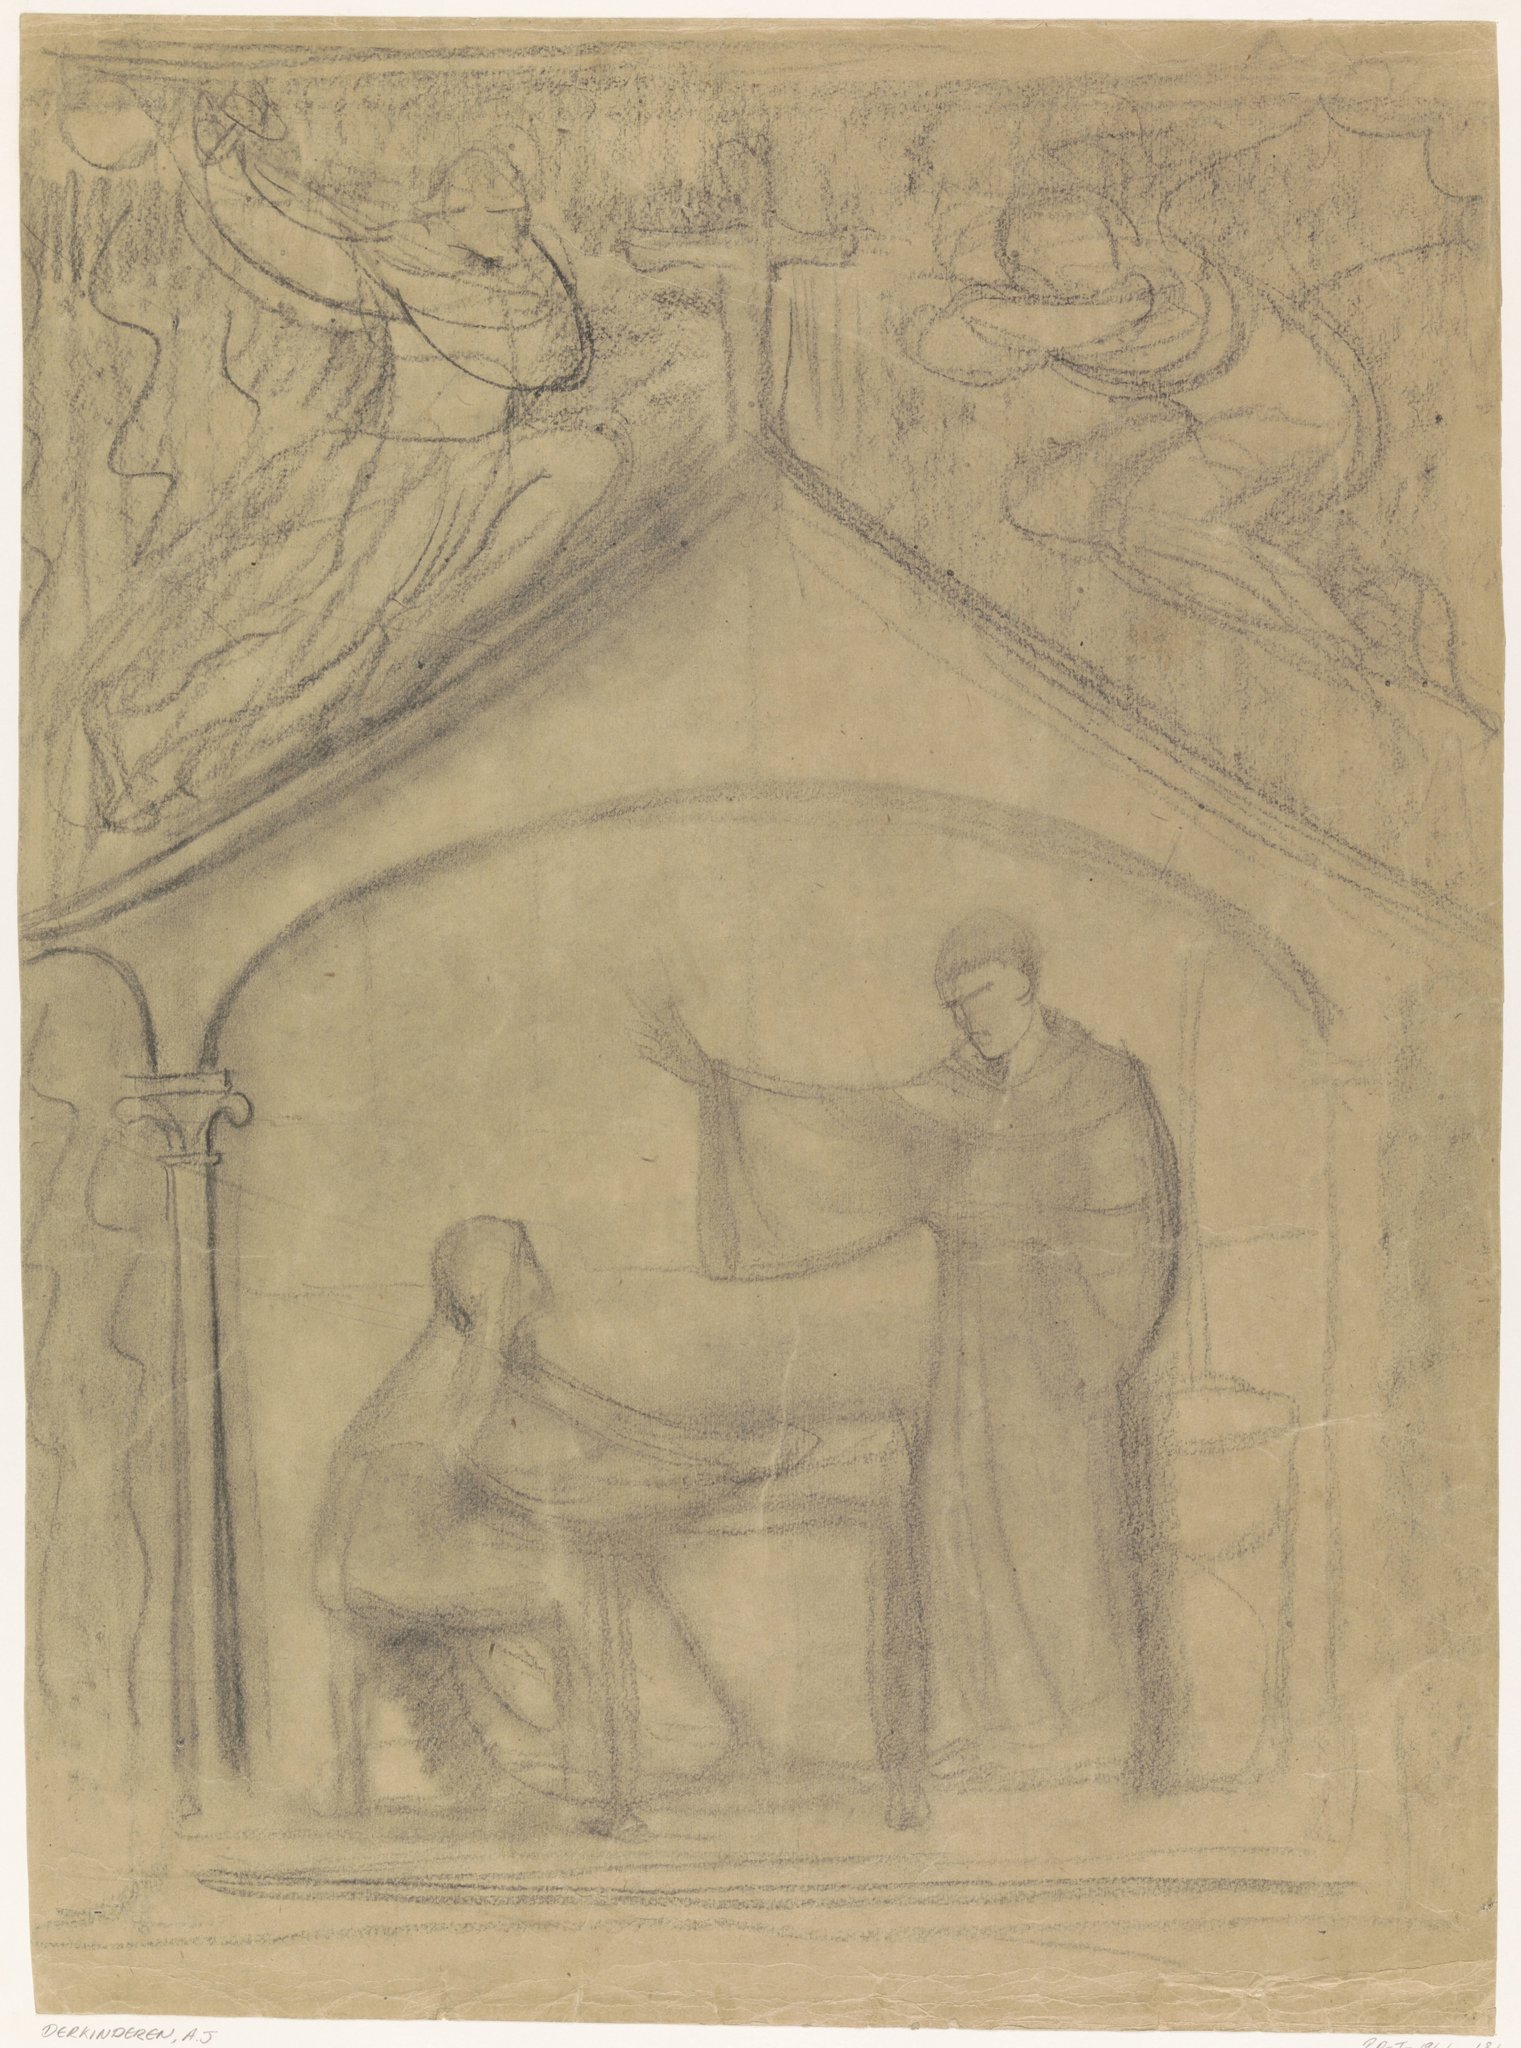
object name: drawing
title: Religieuze voorstelling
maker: antoon derkinderen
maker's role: draughtsman, painter, print maker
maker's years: 1859-1925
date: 1869-1925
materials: chalk, paper